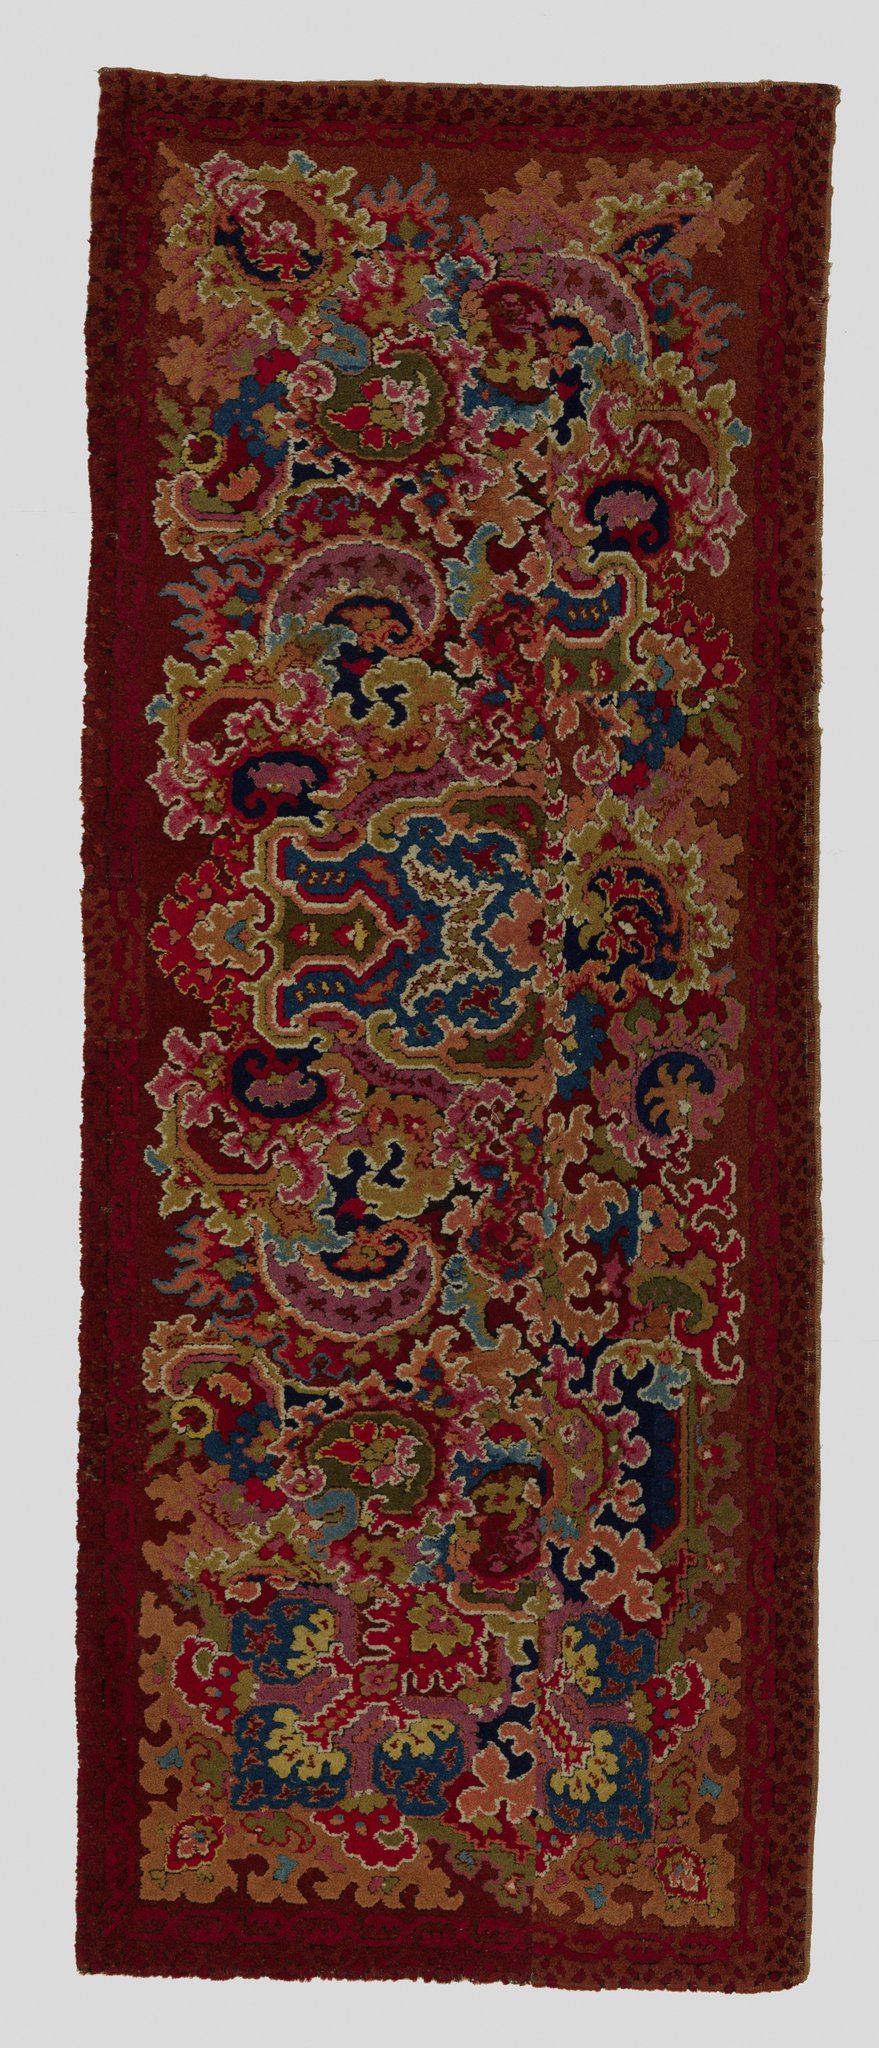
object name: carpet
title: Karpet versierd met palmetten en schulpen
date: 1800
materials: wool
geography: deventer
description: Karpet. Op de donkerrode fond staat in het midden, overdwars geplaatst, een omega-vormige palmet in blauw en groen, met gebroken C-voluten gecontoureerd en geflankeerd door grillige gekartelde schulpen in donkerblauw, rose, oranje, mosterdgeel, rood en violet; alle schulpen zijn opgebouwd uit concentrische vormen in verschillende nuances, en door zwarte of witte lijn omrand. In twee hoeken een schuin gerichte rode palmet, waaruit een tak ontspringt met drie blauwe palmetten. Ook hiervan zijn de contouren veelkleurig omrand en met grillig uitgegroeide schulpen omgeven. De rand vertoont pantervlekken in diverse nuances donkerrood en een binnenzoom als een hoekige schakelketen in steenrood. Samengesteld uit fragmenten van een veel groter vloerkleed. Zodanig dat geen zuiver patroon gevormd wordt.